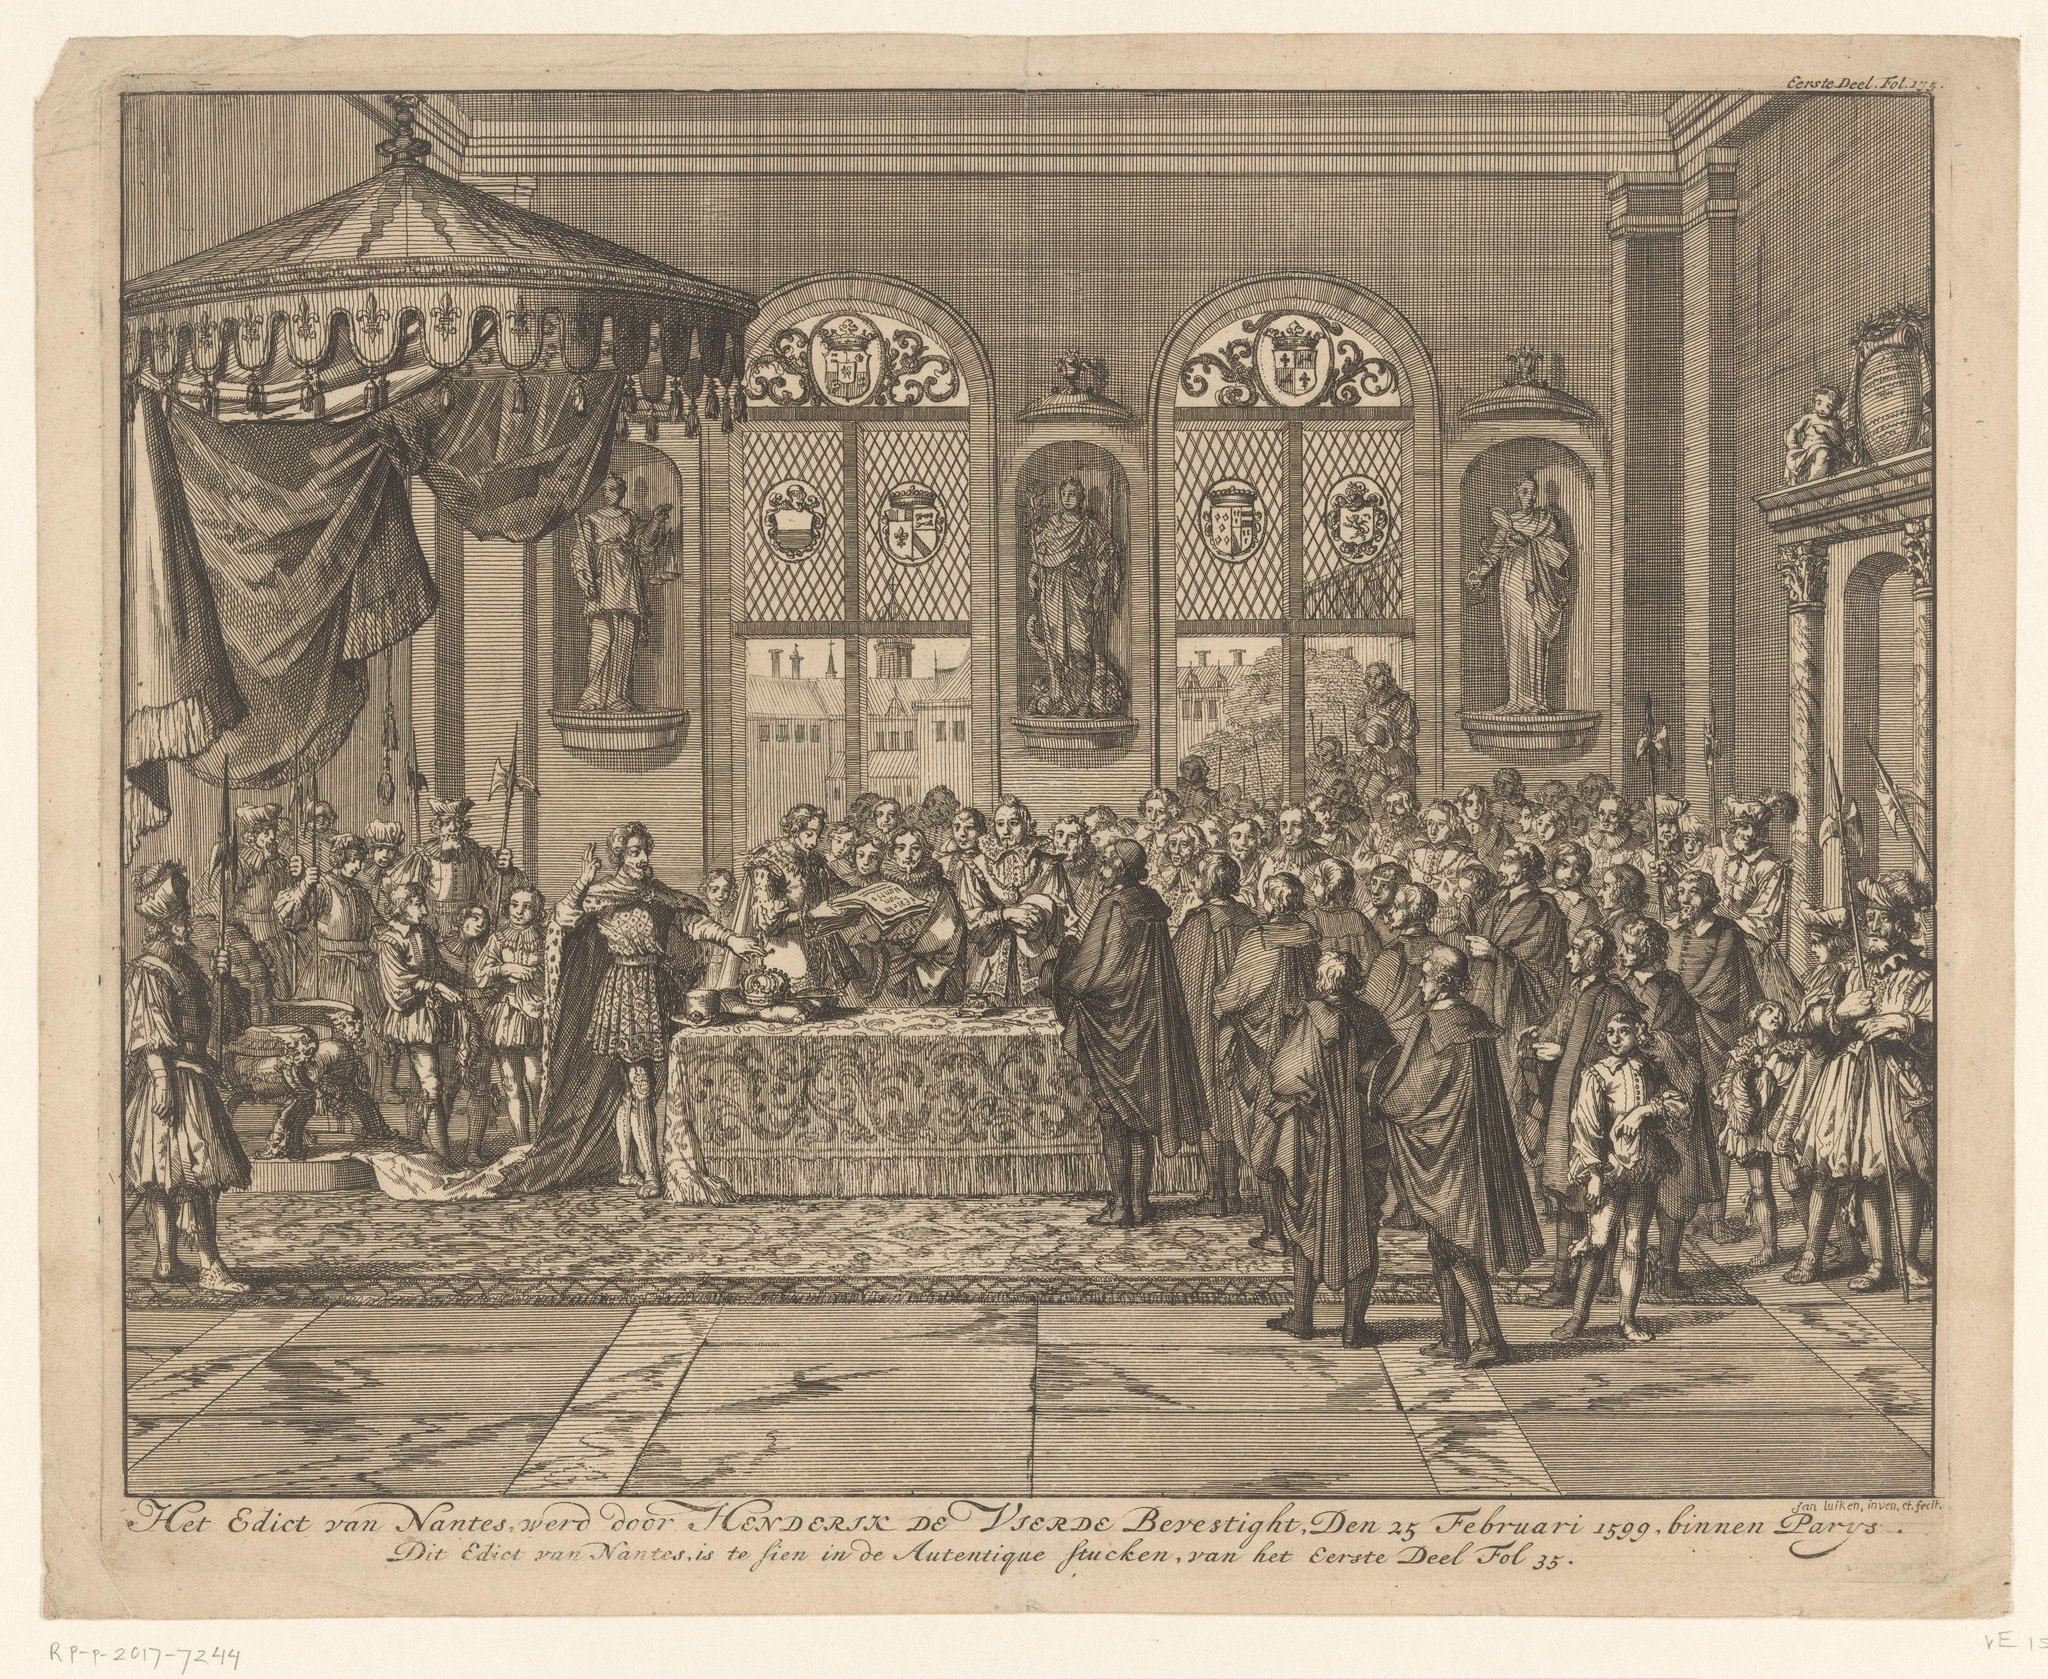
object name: print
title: Het Edict van Nantes, werd door Hendrik de Vierde Bevestight, Den 25 Februari 1599, binnen Parys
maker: jan luyken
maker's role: draughtsman, print maker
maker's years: 1649-1712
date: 1696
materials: paper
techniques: etching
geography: amsterdam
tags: paris, hendrik iv (koning van frankrijk en navarra), meeting, assembly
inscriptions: collector's mark: Lugt 2228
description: Gebruikt als illustratie in: Elie Benoist, Historie der gereformeerde kerken van Vrankryk, 4 delen. Amsterdam: Jan Claesz ten Hoorn, 1696, dl. I.